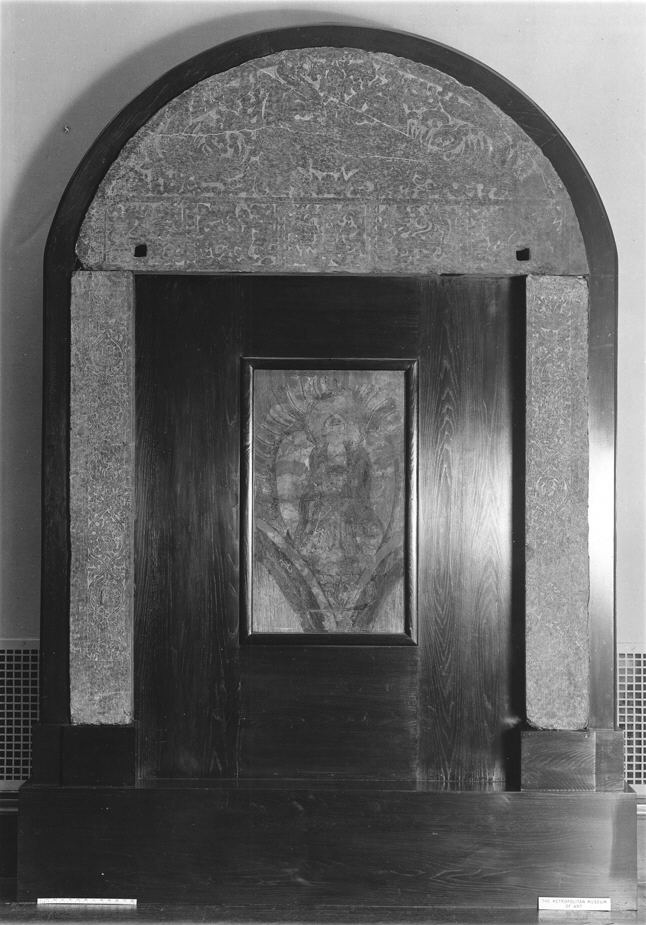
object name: wall painting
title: Buddha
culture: chinese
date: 301-400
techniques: painting